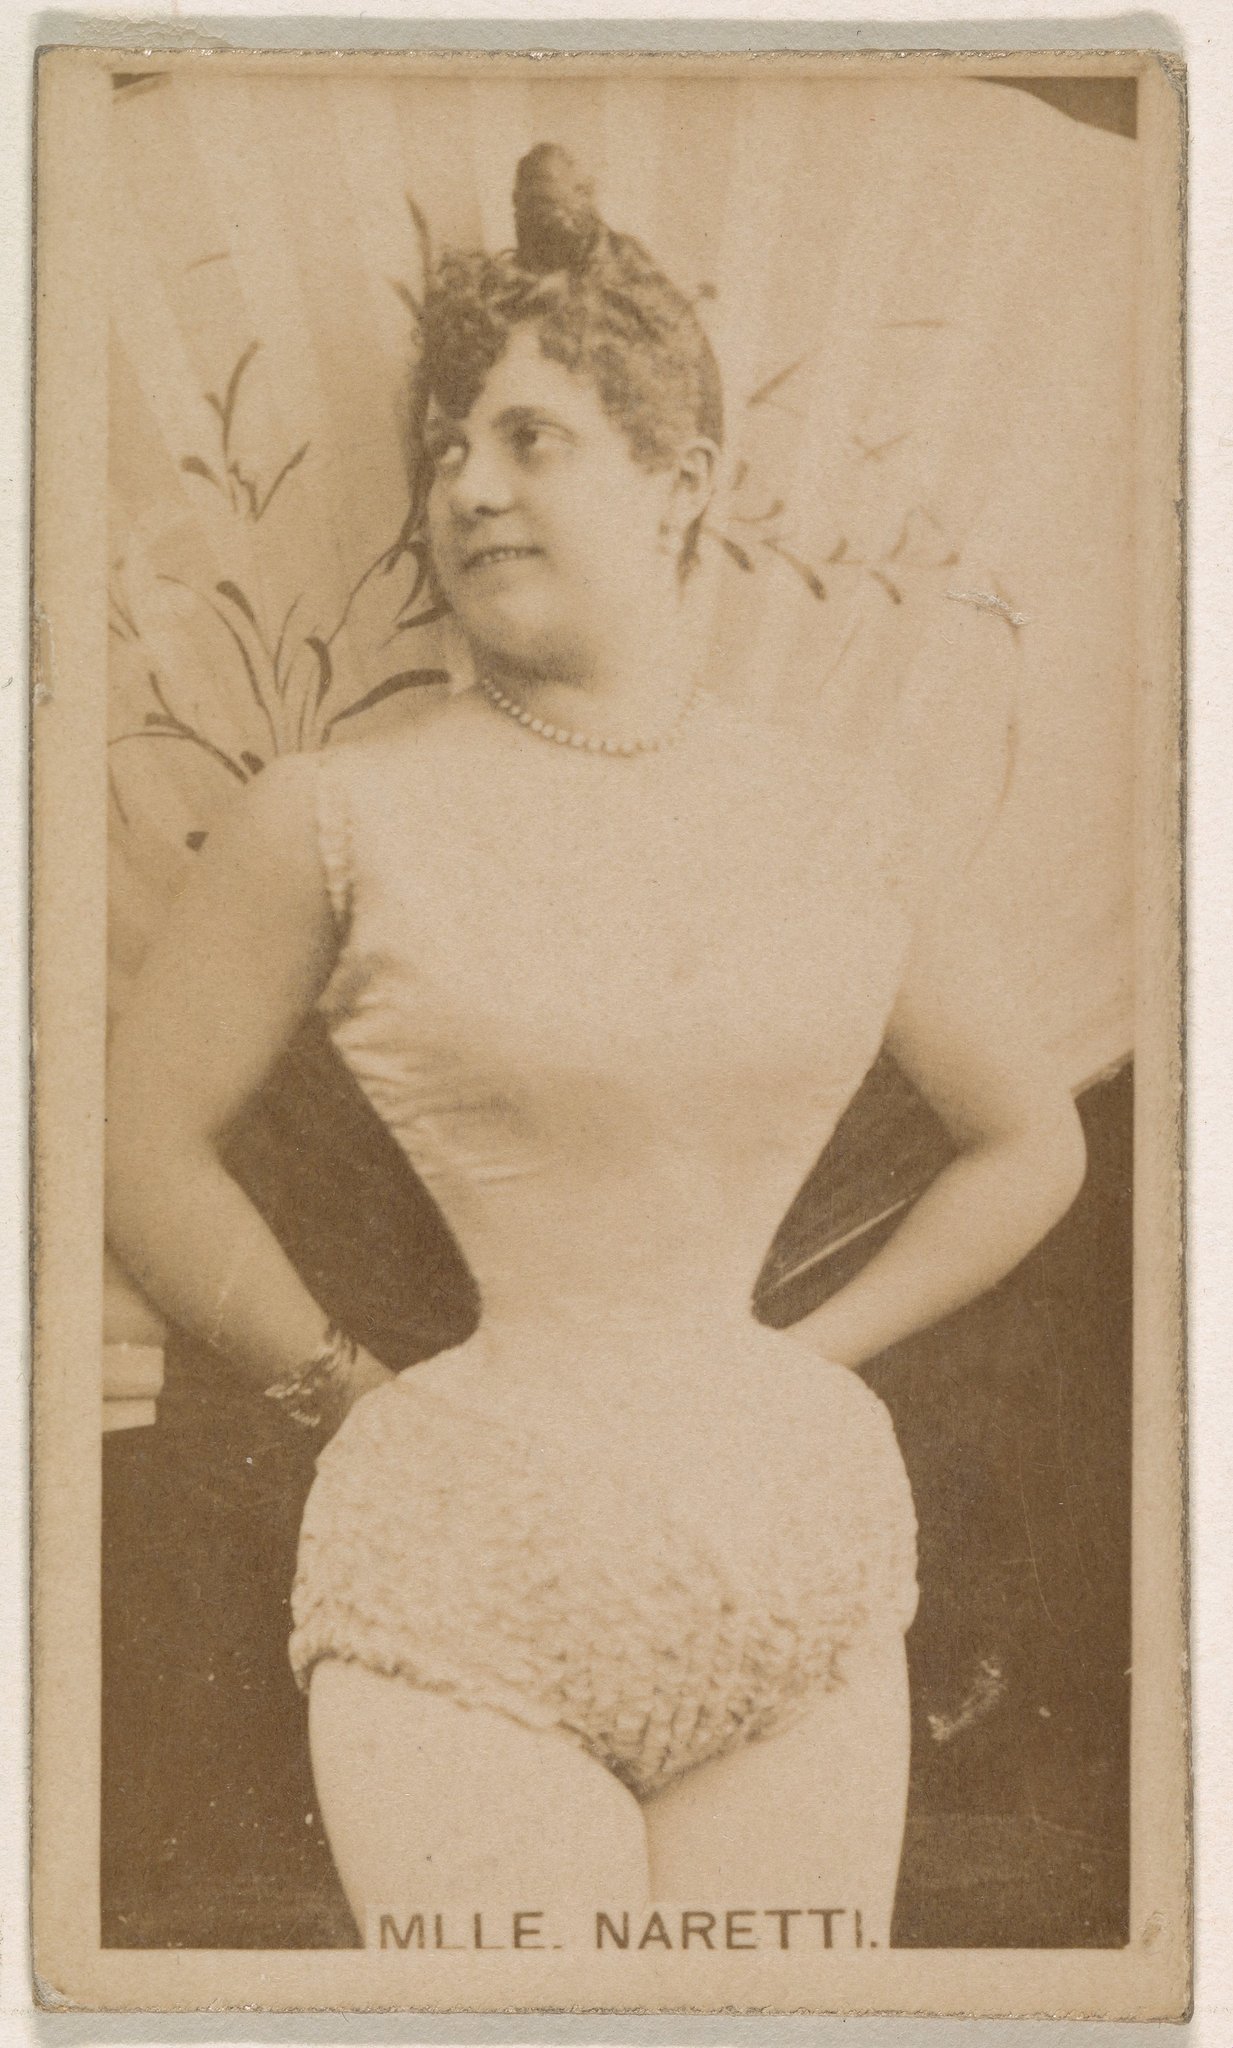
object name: photograph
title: Mlle. Naretti, from the Actresses series (N245) issued by Kinney Brothers to promote Sweet Caporal Cigarettes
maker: kinney brothers tobacco company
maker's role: publisher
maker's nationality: american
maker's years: 1869-2011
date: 1890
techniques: albumen silver print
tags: portraits,women,actresses